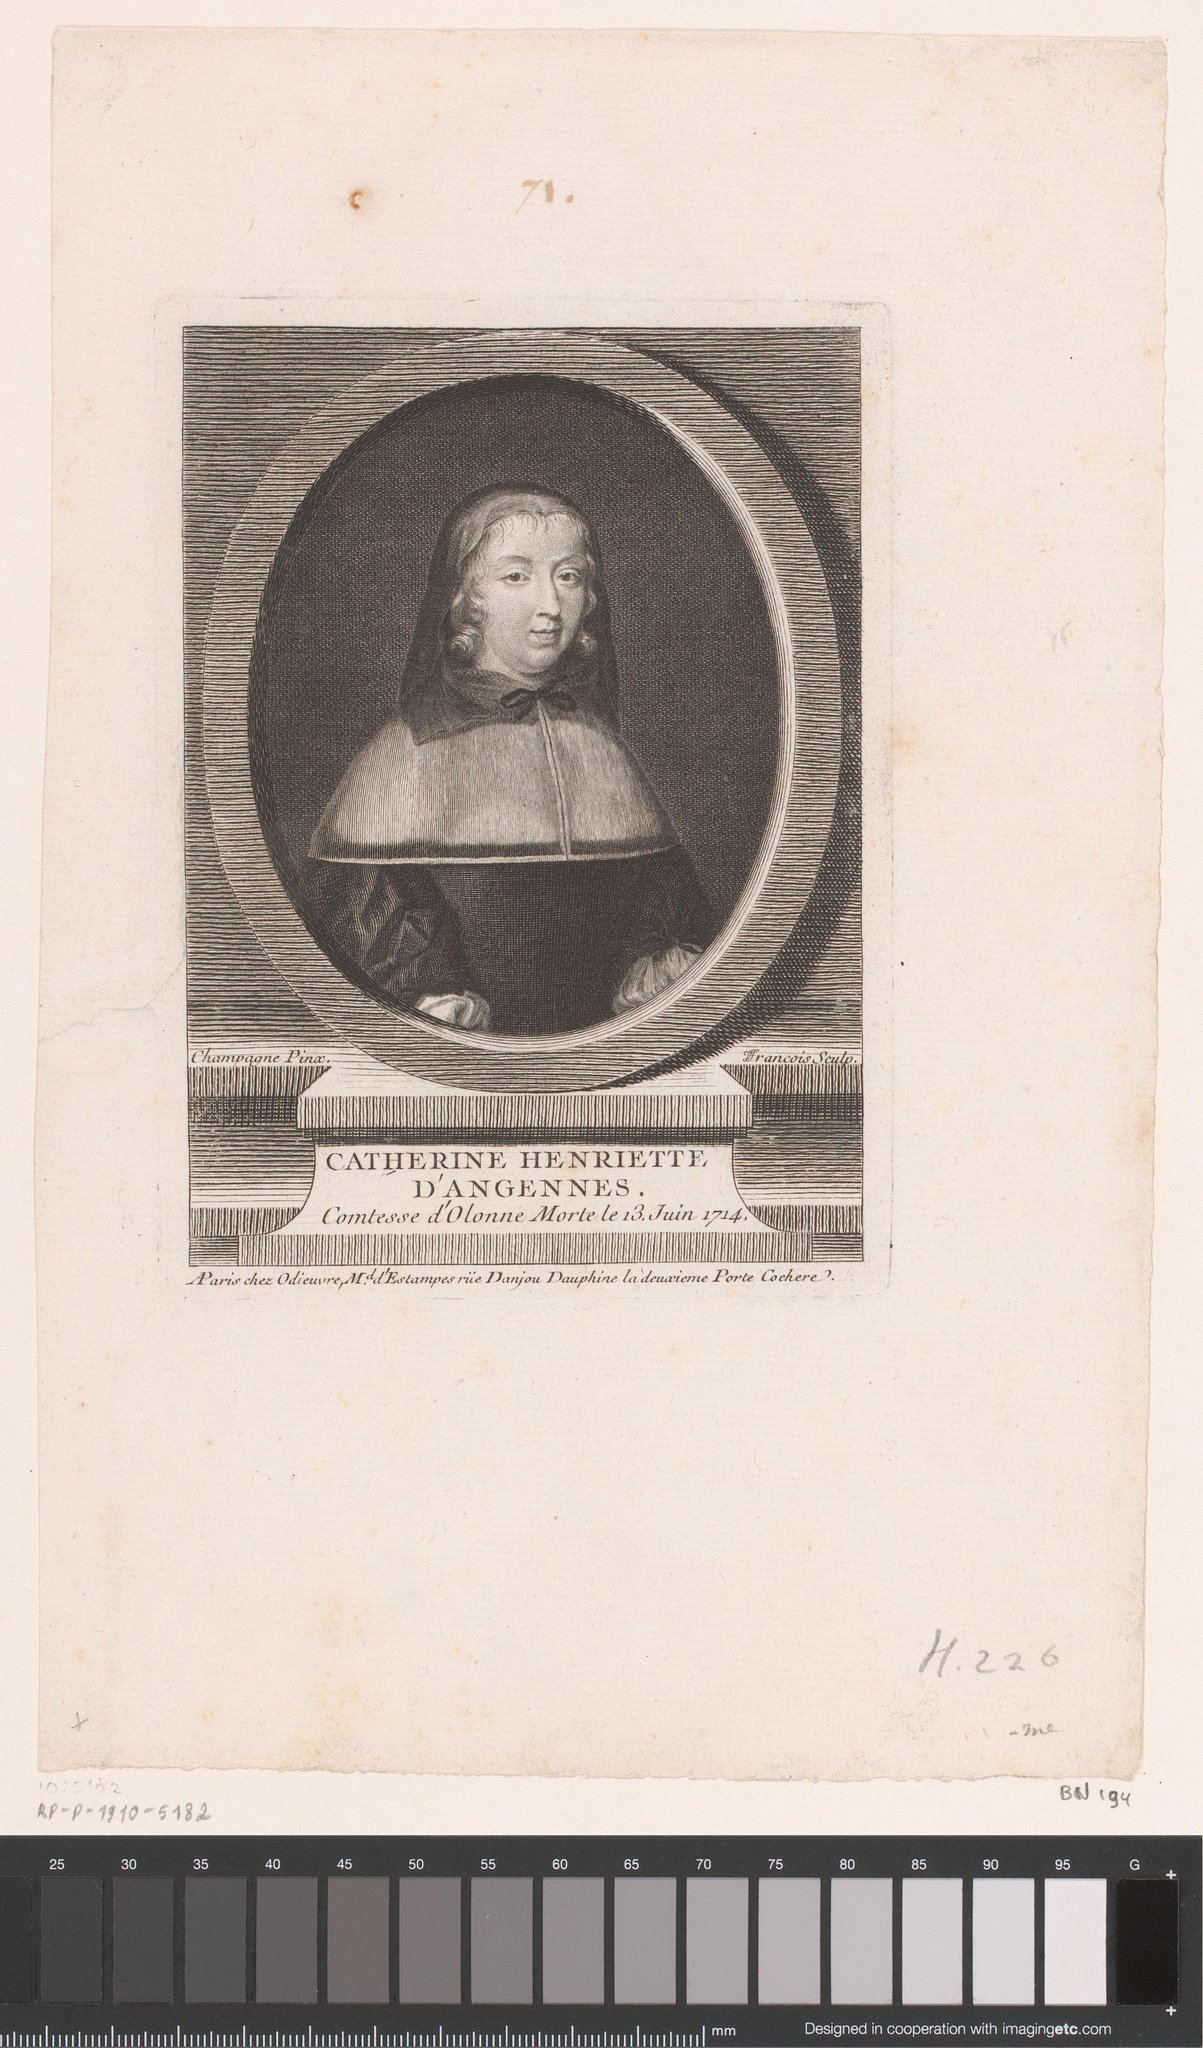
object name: book illustration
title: Portret van Catherine Henriette d'Angennes, gravin van Olonne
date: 1755-1765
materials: paper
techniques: engraving, etching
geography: paris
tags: historical persons - bb - woman, ornament ~ medallion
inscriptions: collector's mark: Lugt 2228, inscription: ‘71.’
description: Prent uit: Dreux du Radier, Jean-François. L'Europe illustré, contenant l'histoire abregée des souverains, des princes, des prélats, des ministres, (...) en Europe: dans le XVe. siècle compris, jusqu'à présent. Parijs: Michel Odieuvre en Jean-Luc Nyon, 1755-1765.